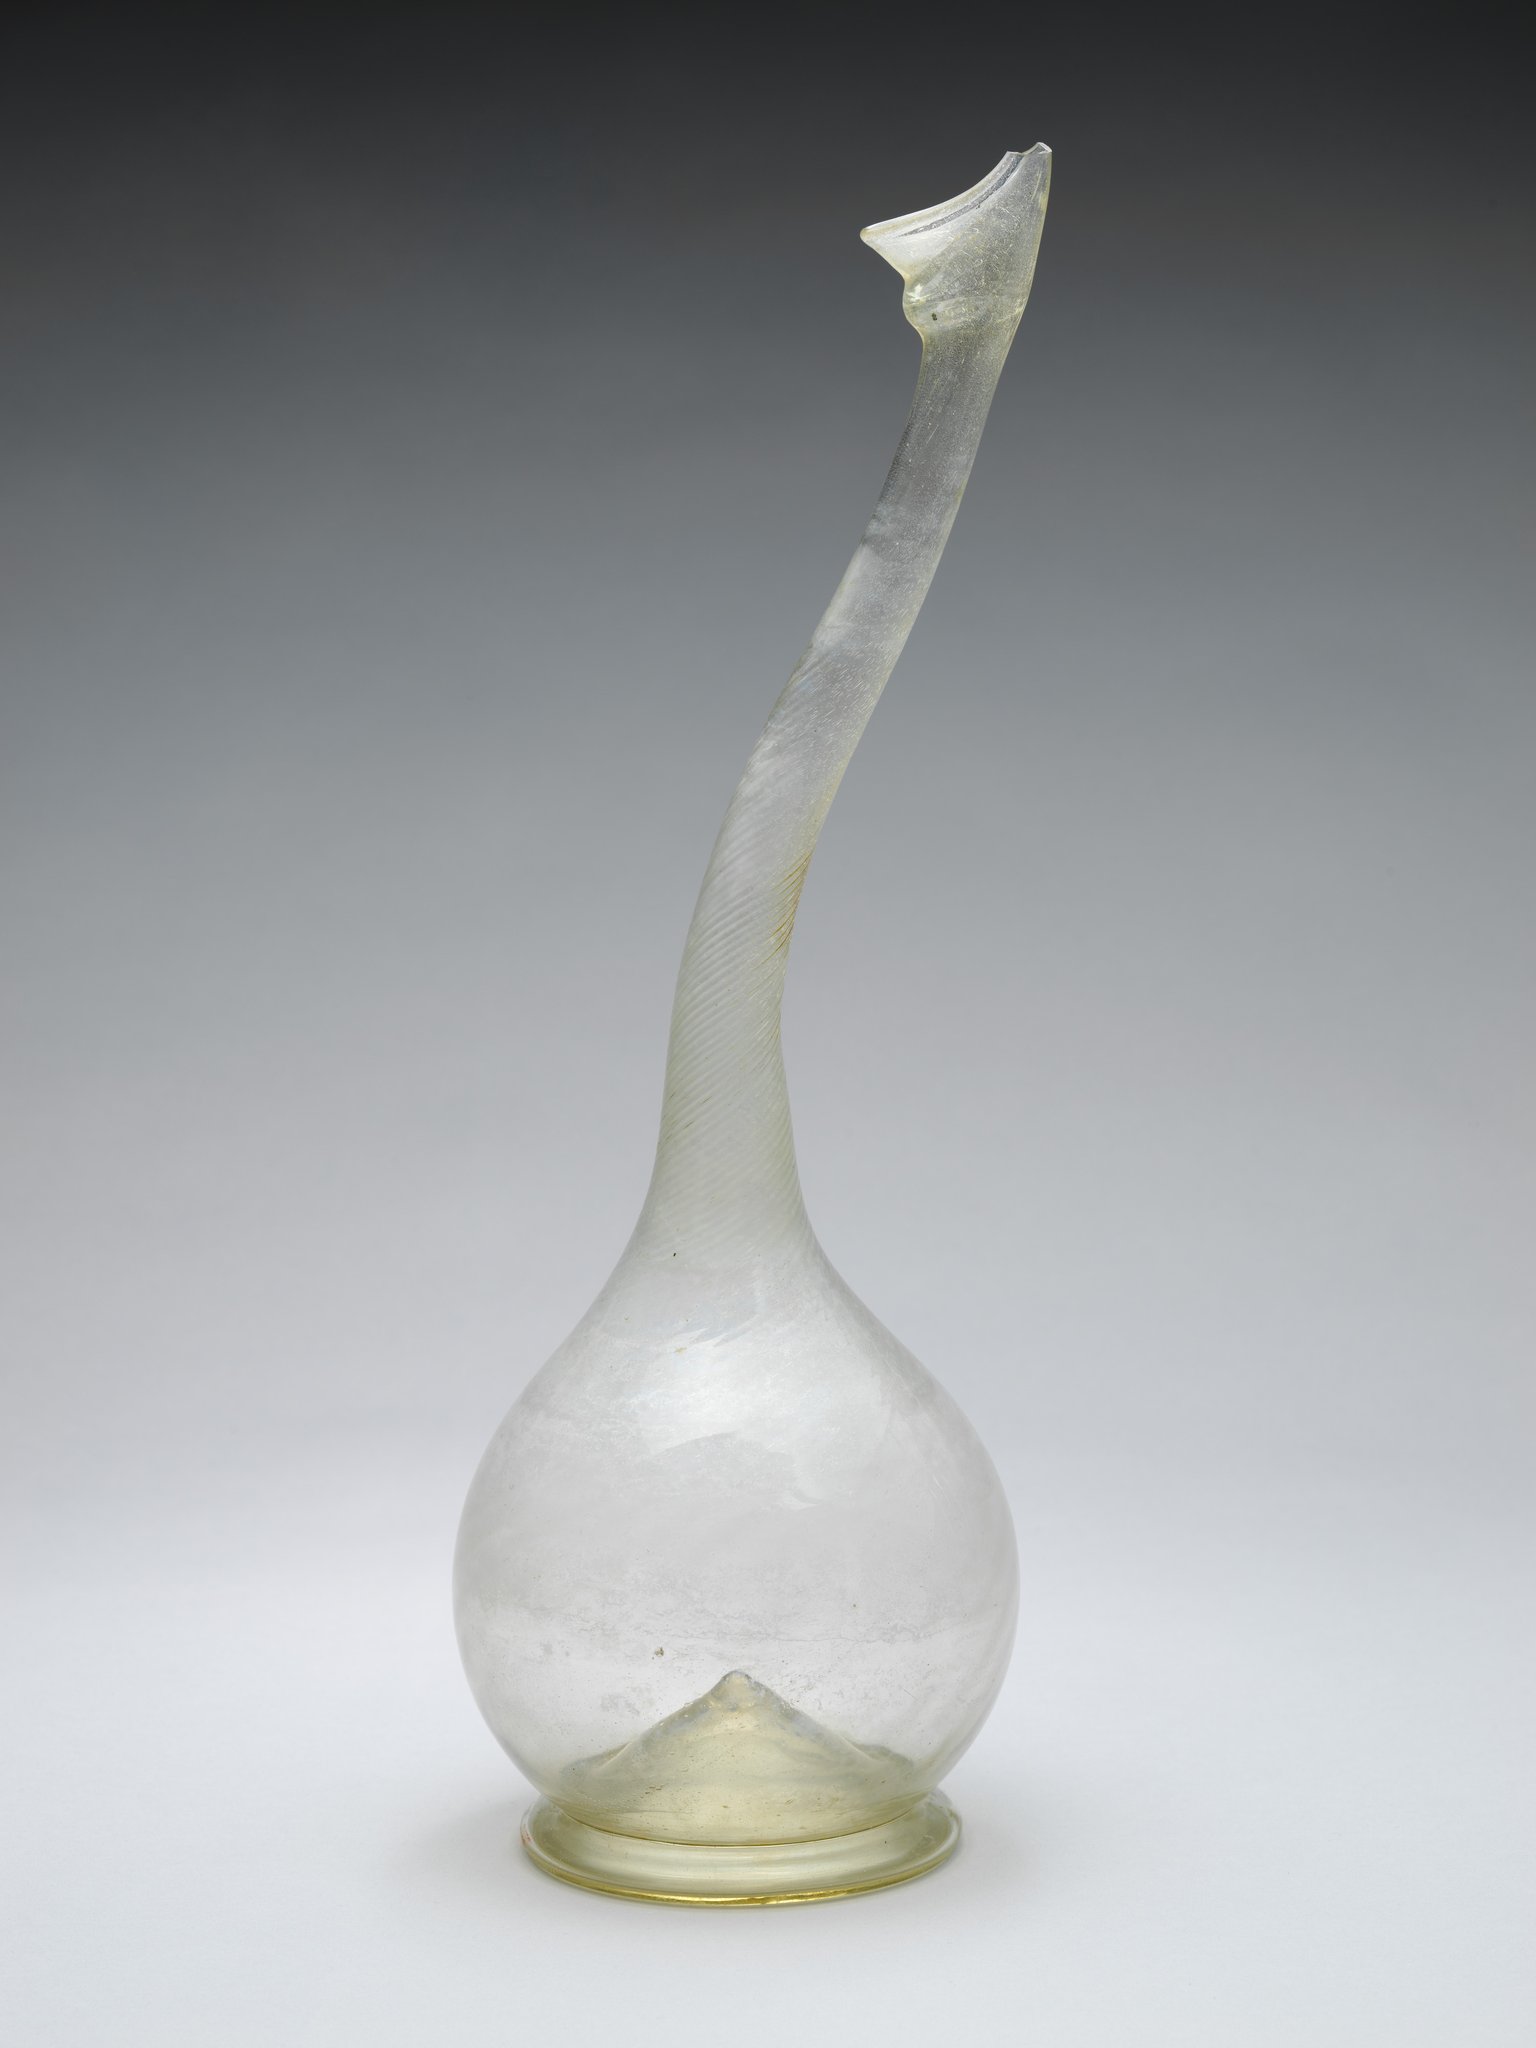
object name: sprinkler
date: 1701-1900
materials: glass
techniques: glassblowing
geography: iran